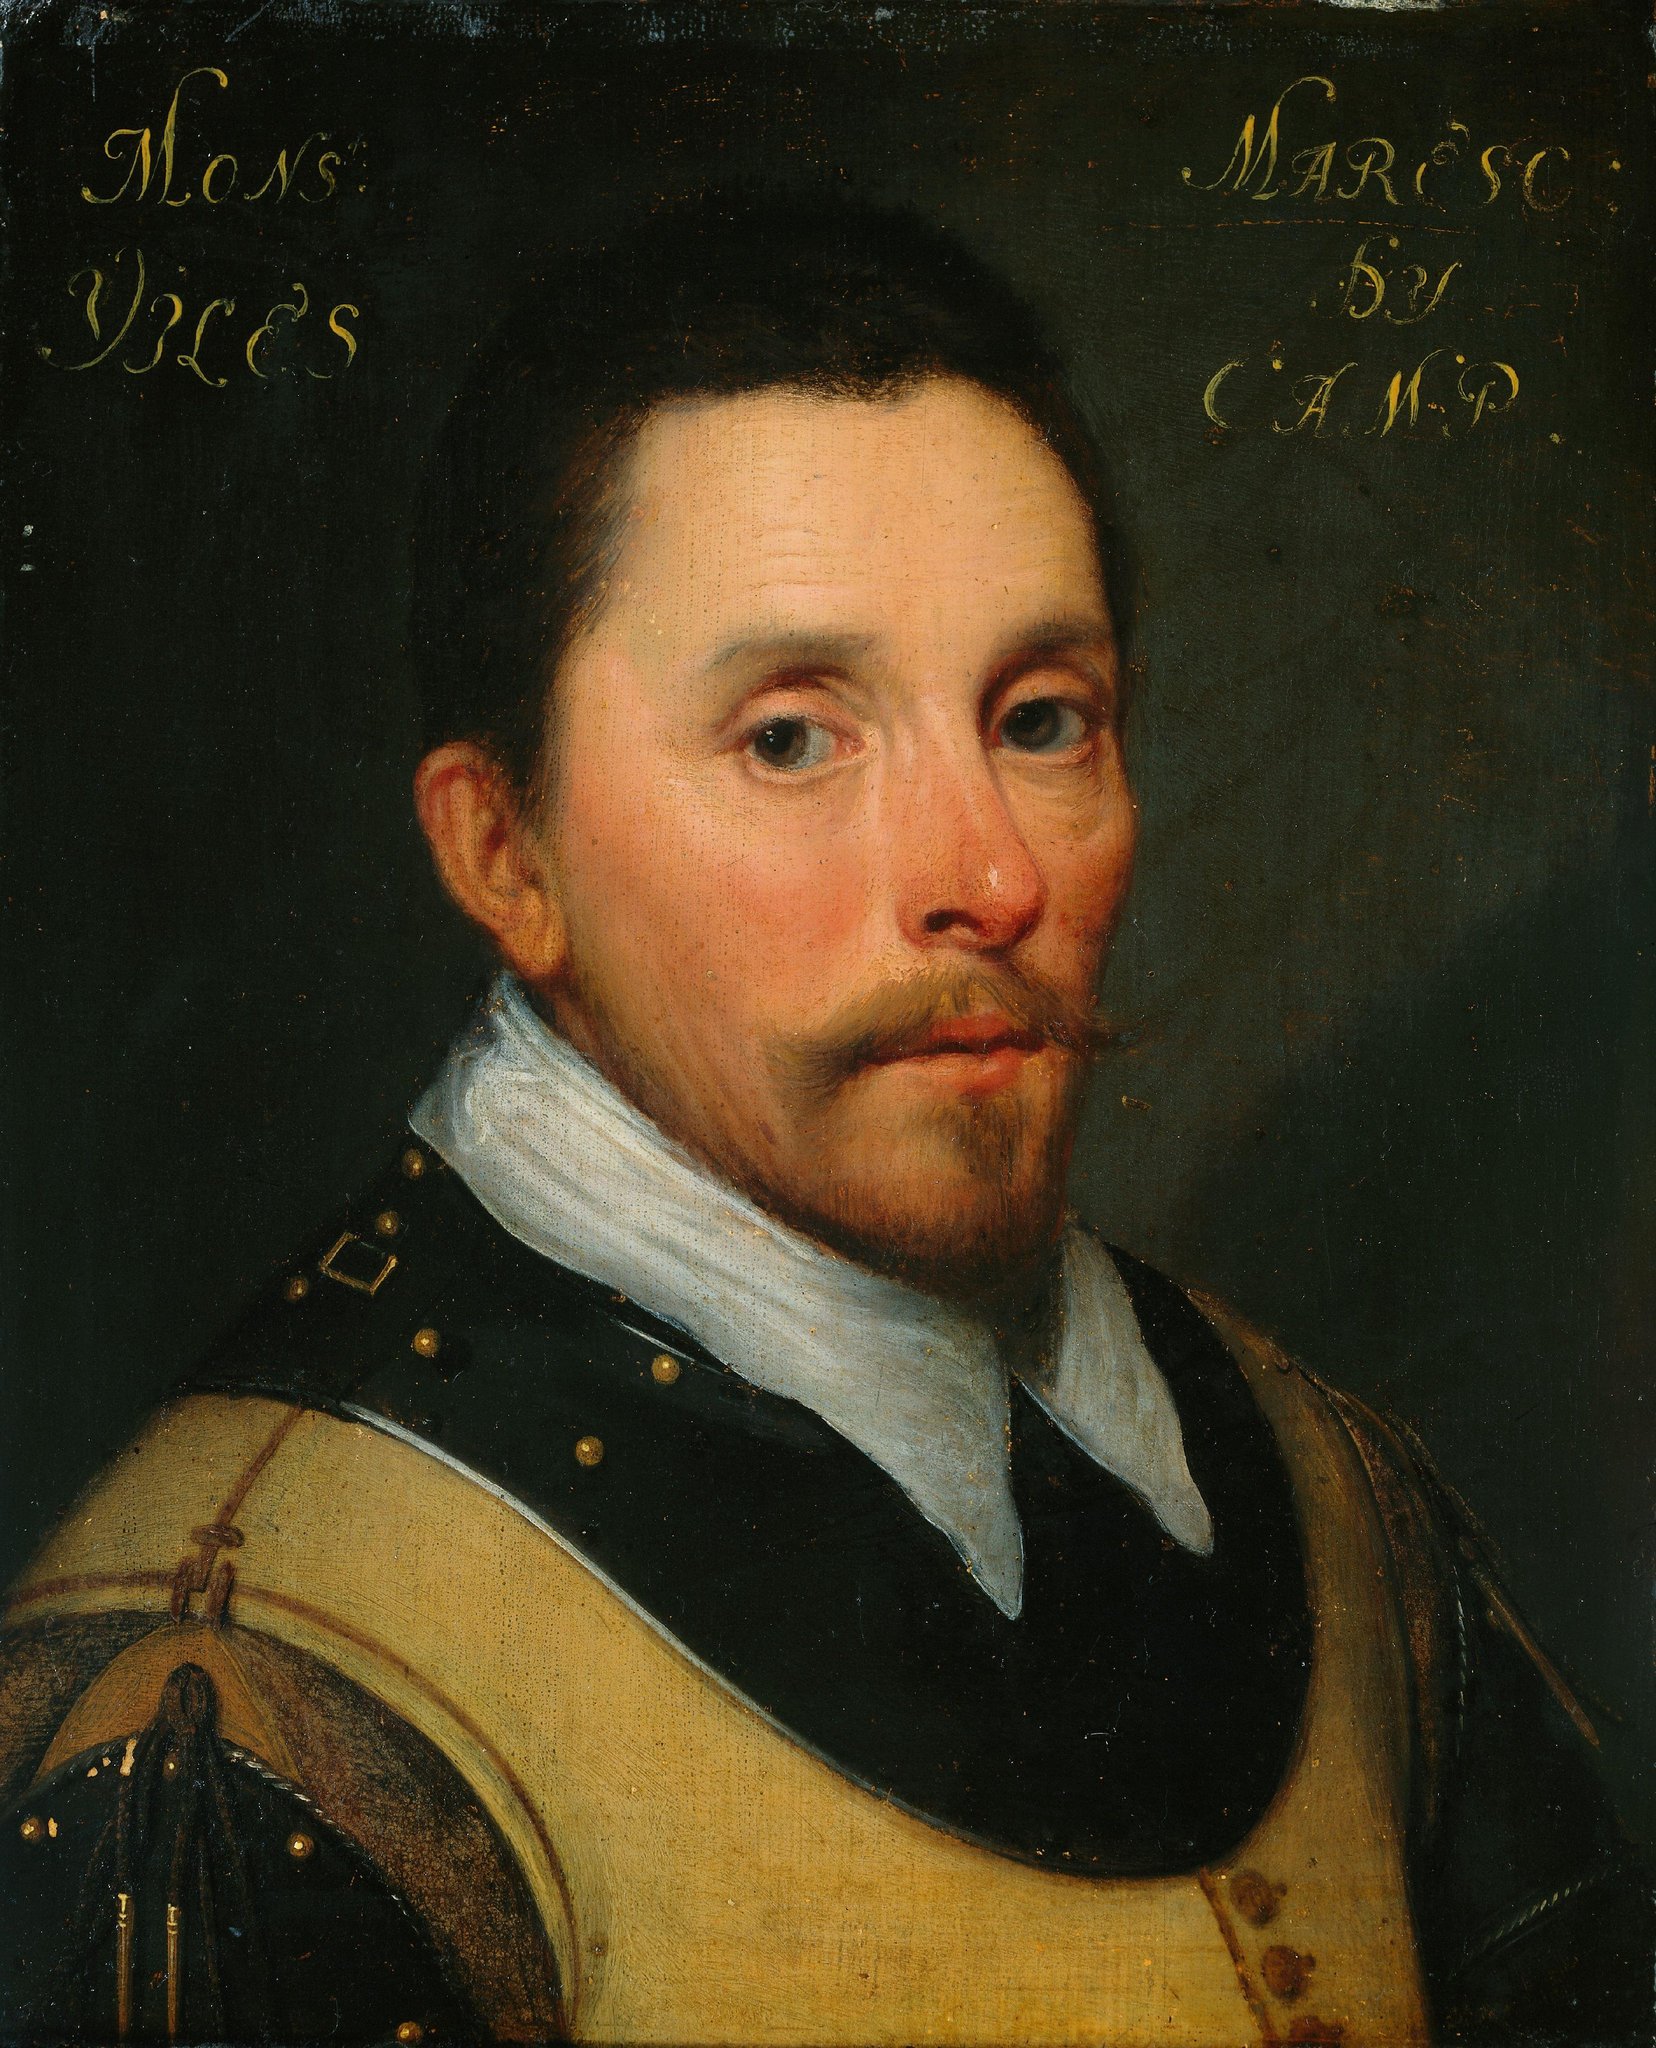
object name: painting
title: Portrait of Joost de Zoete (?-1589), Lord of Villers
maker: jan antonisz van ravesteyn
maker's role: draughtsman, painter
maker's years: 1570-1657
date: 1609-1633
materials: oil, panel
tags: historical persons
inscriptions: inscription, top: ‘Mons.r Viles Maresc: by Camp.’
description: Joost de Zoete, heer van Villiers (?-1589), naar J.A. van Ravesteyn.